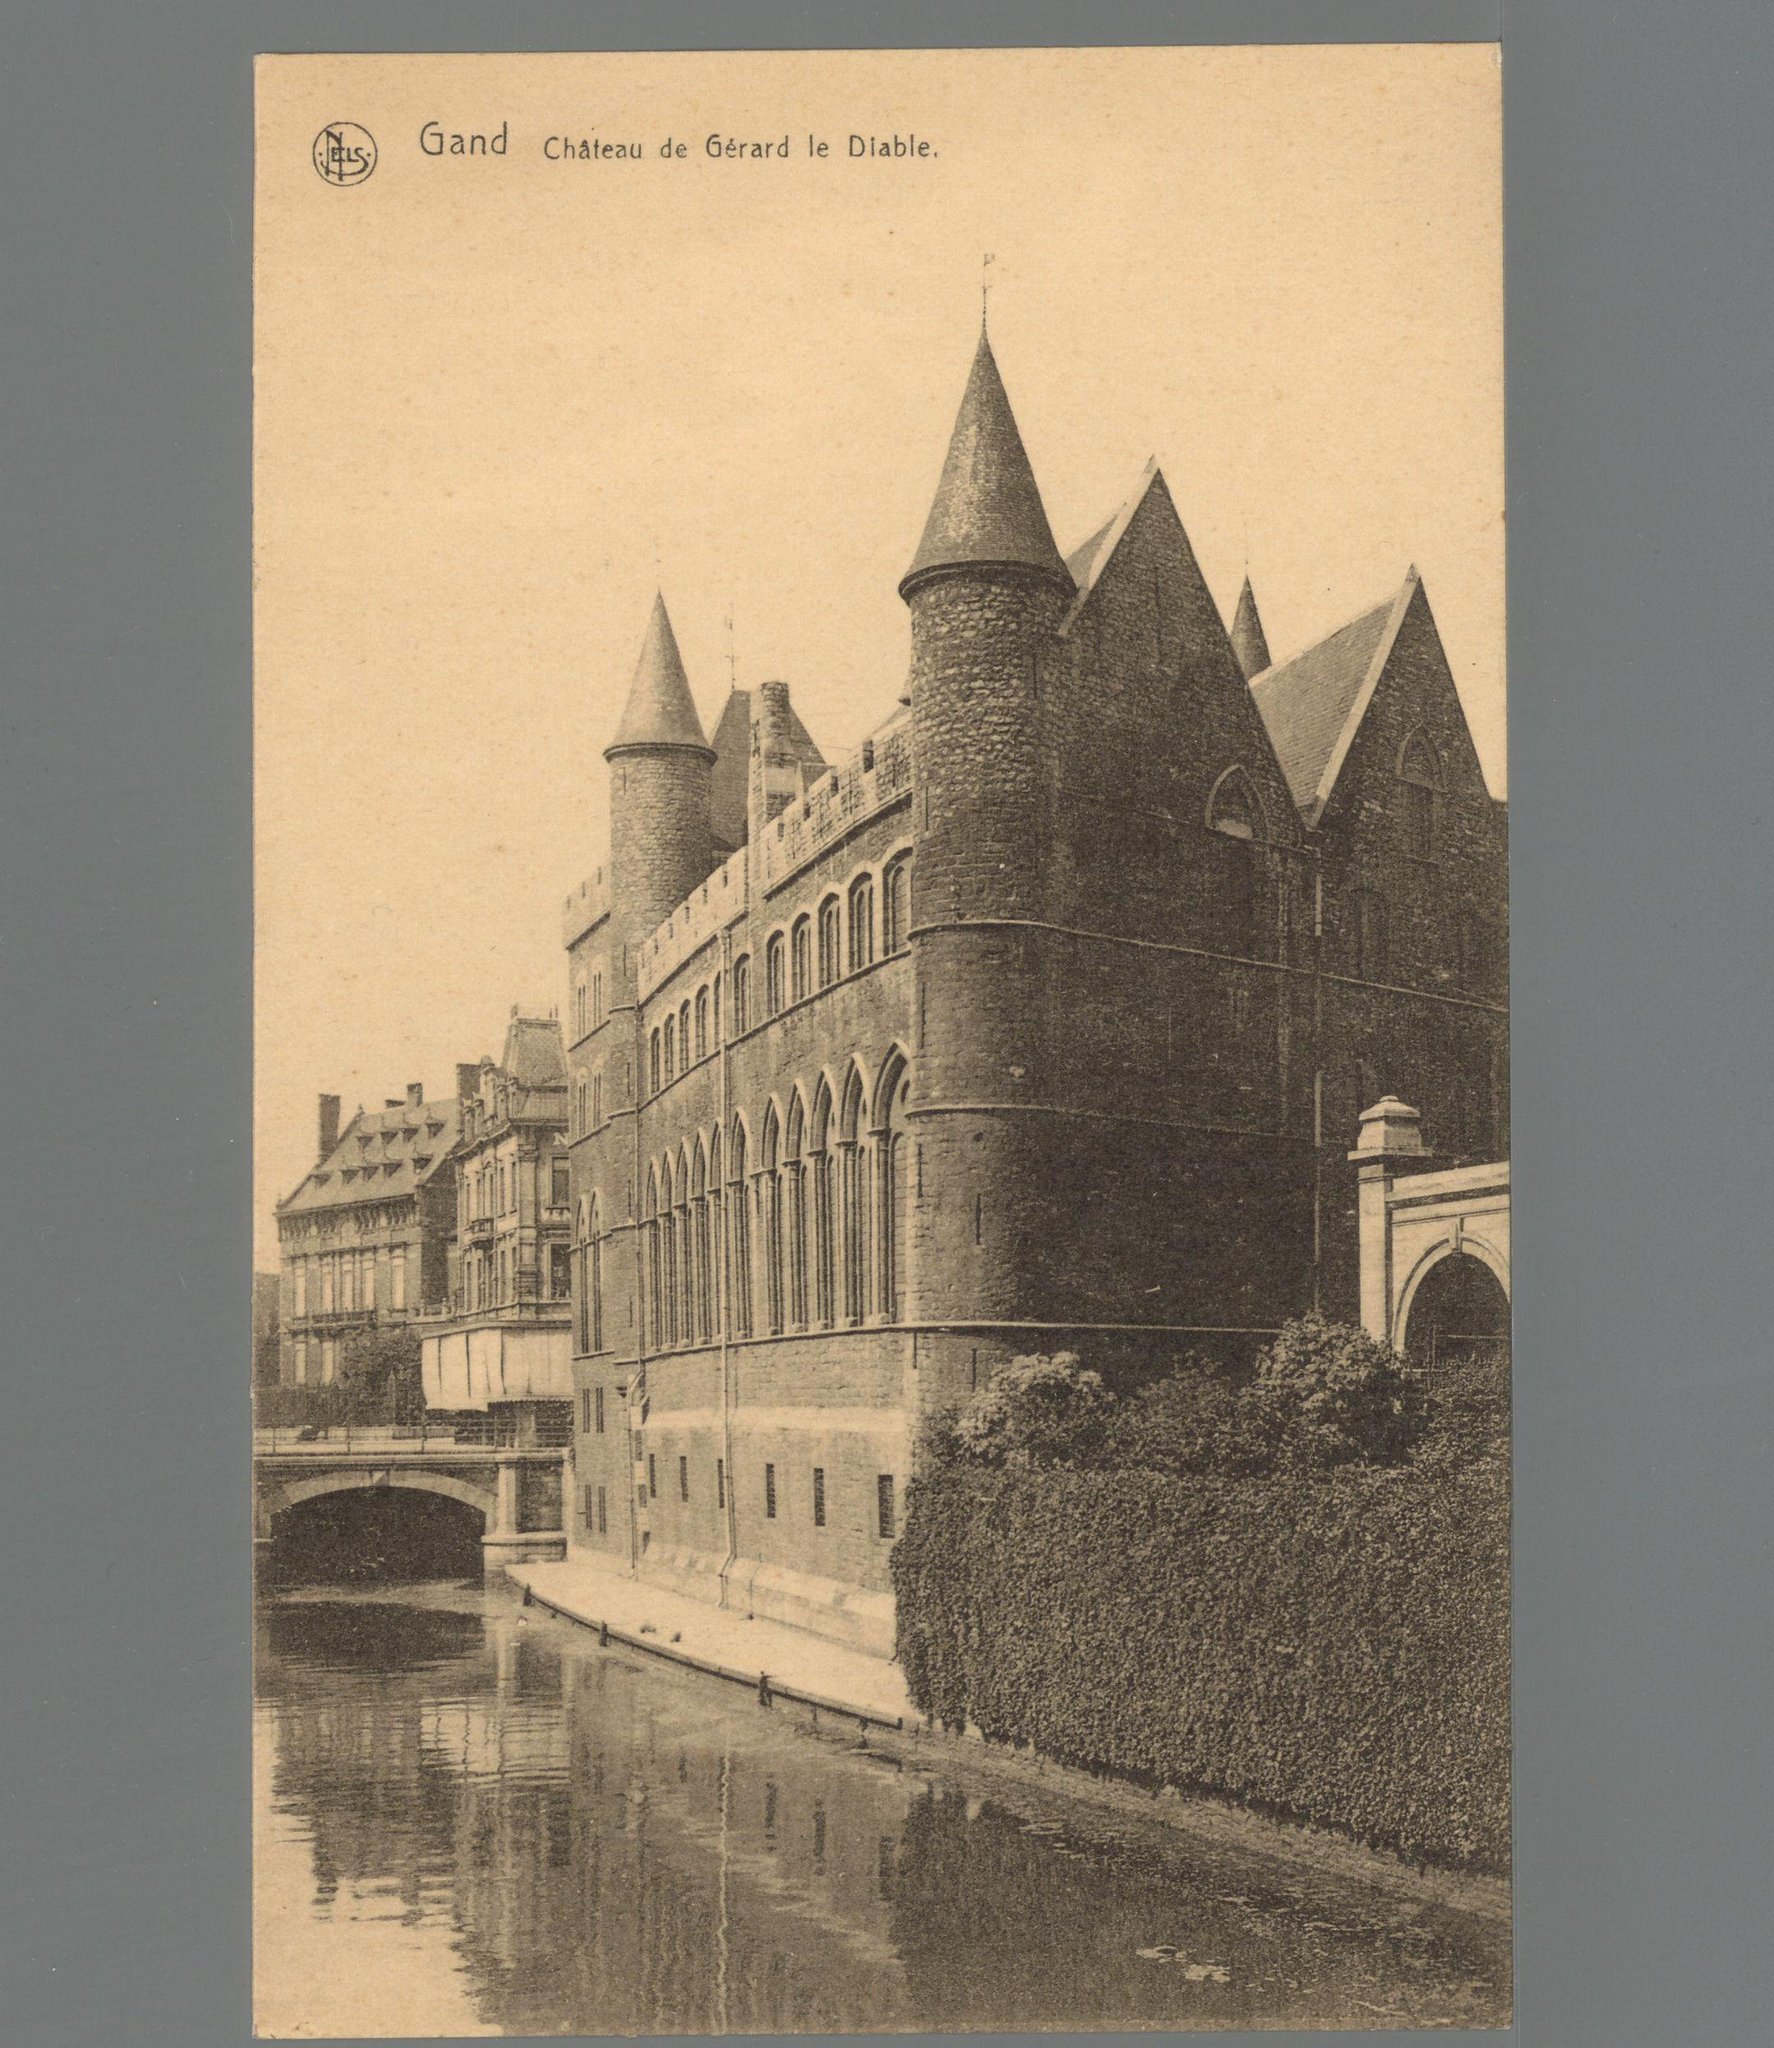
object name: ansichtkaart, prentbriefkaart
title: Gand. Château de Gérard le Diable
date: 1913-1930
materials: cardboard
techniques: photograph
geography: brussels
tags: city-view, and landscape with man-made constructions, river, edifice, e.g.: public building, department store, ghent